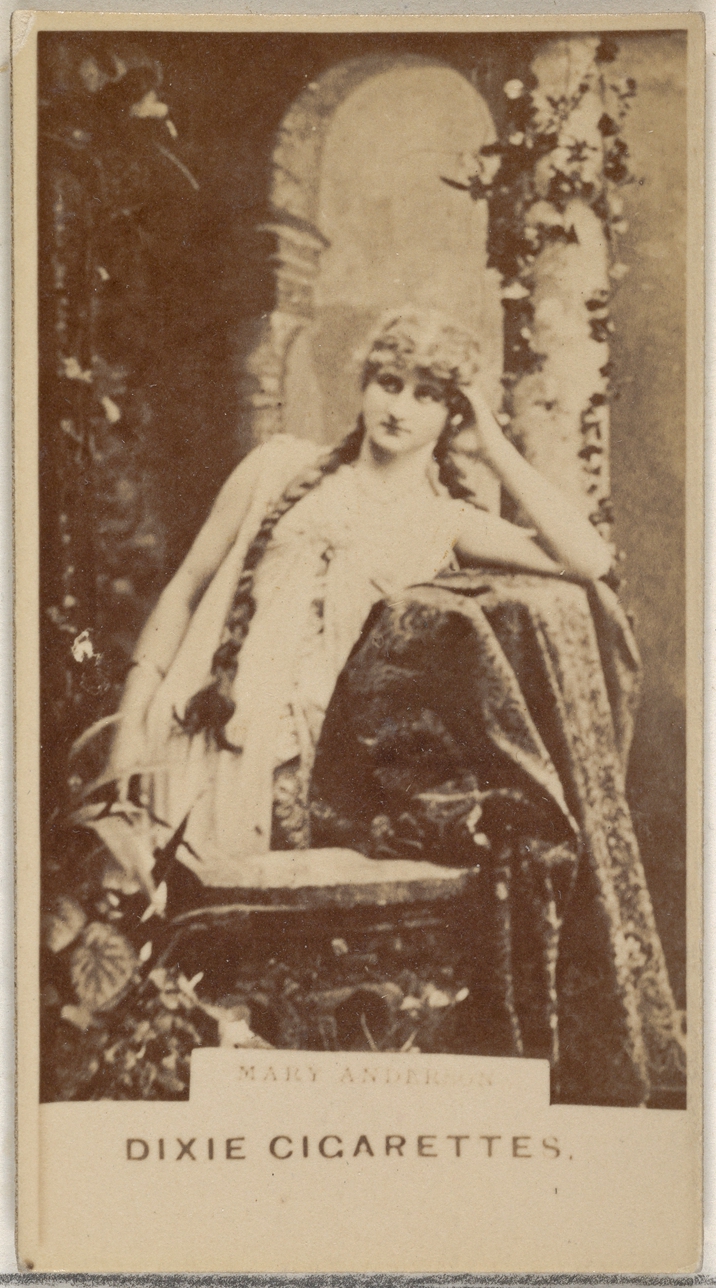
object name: photograph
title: Mary Anderson, from the Actors and Actresses series (N45, Type 7) for Dixie Cigarettes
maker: allen & ginter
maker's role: publisher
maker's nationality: american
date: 1888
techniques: albumen silver print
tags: portraits,women,actresses